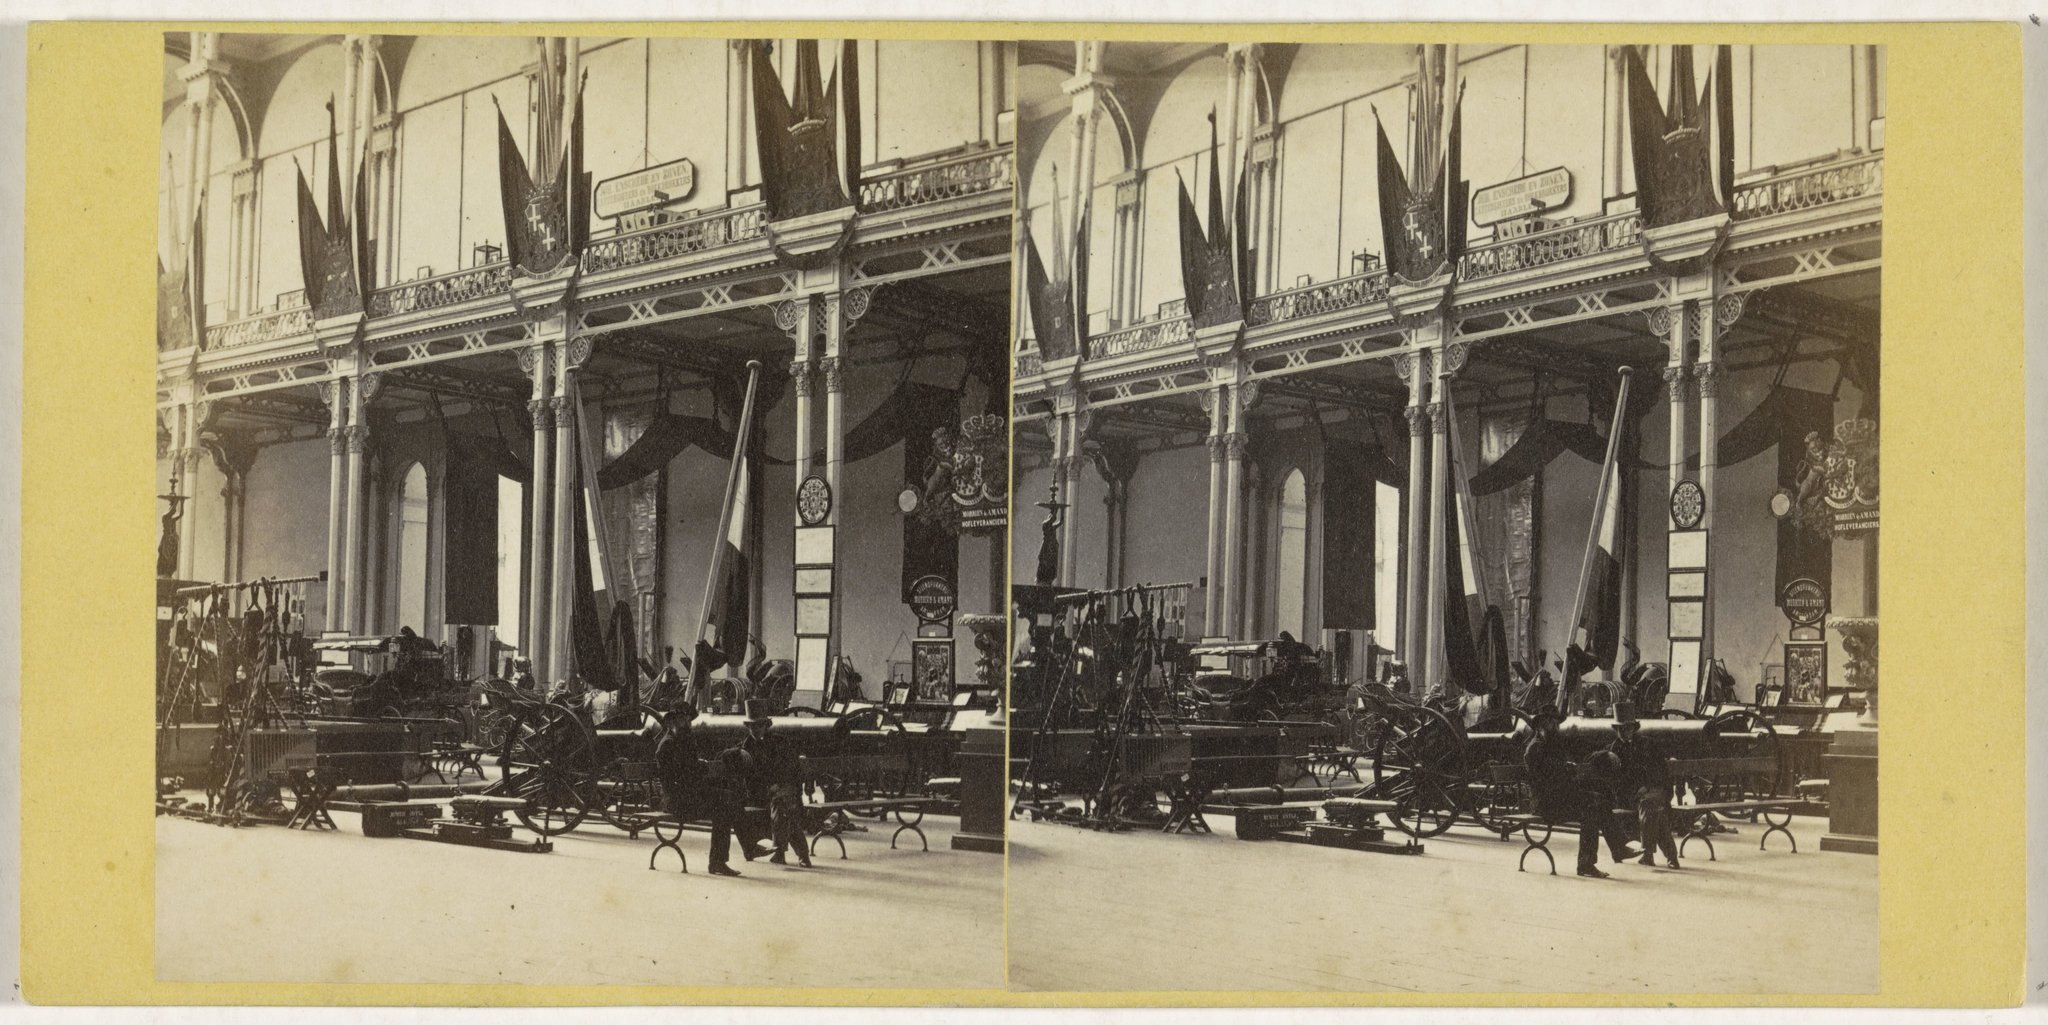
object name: stereograph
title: Zaal met uitgestalde objecten bij de Tentoonstelling voor Nationale Nijverheid en Kunst in het Paleis voor Volksvlijt, Amsterdam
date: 1866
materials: cardboard, paper, photographic support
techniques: albumen print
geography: amsterdam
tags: amsterdam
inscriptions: label: ‘Boek & Kunsthandel Jan D. Brouwer, Kalverstraat E, Nº 37 Amsterdam.’, stamp: ‘JDB’